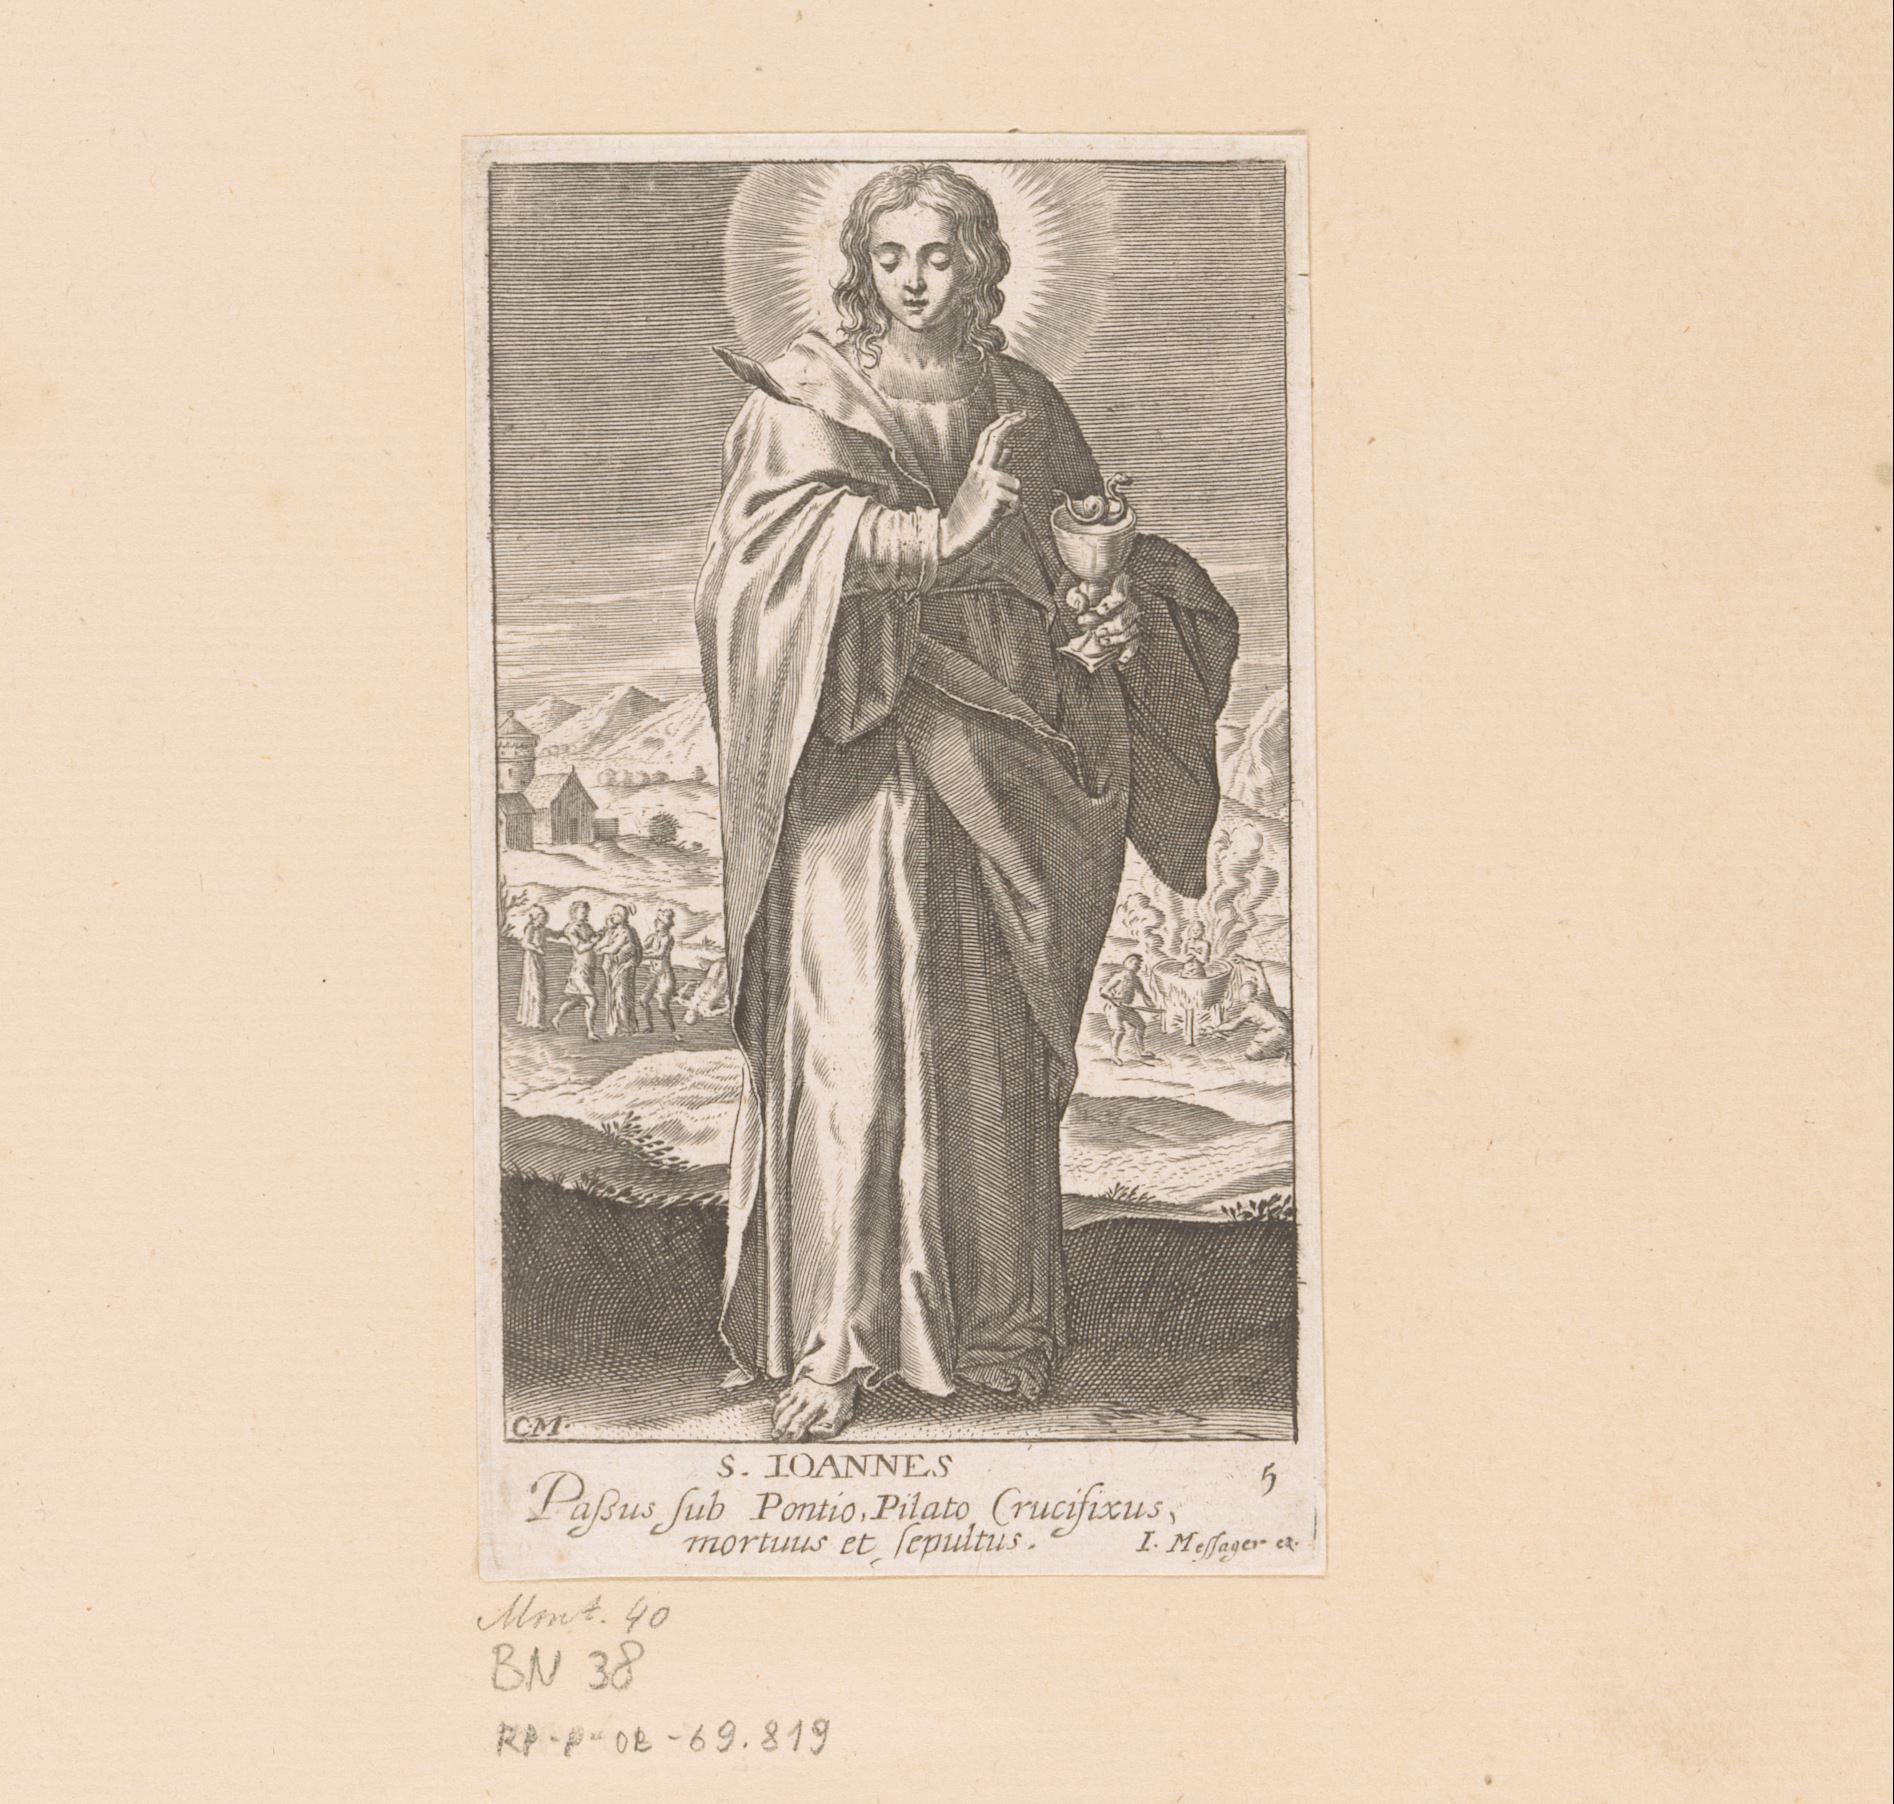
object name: print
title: H. Johannes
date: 1608-1649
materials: paper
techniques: engraving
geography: france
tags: series of scenes from the life of john the baptist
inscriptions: collector's mark: Lugt 240